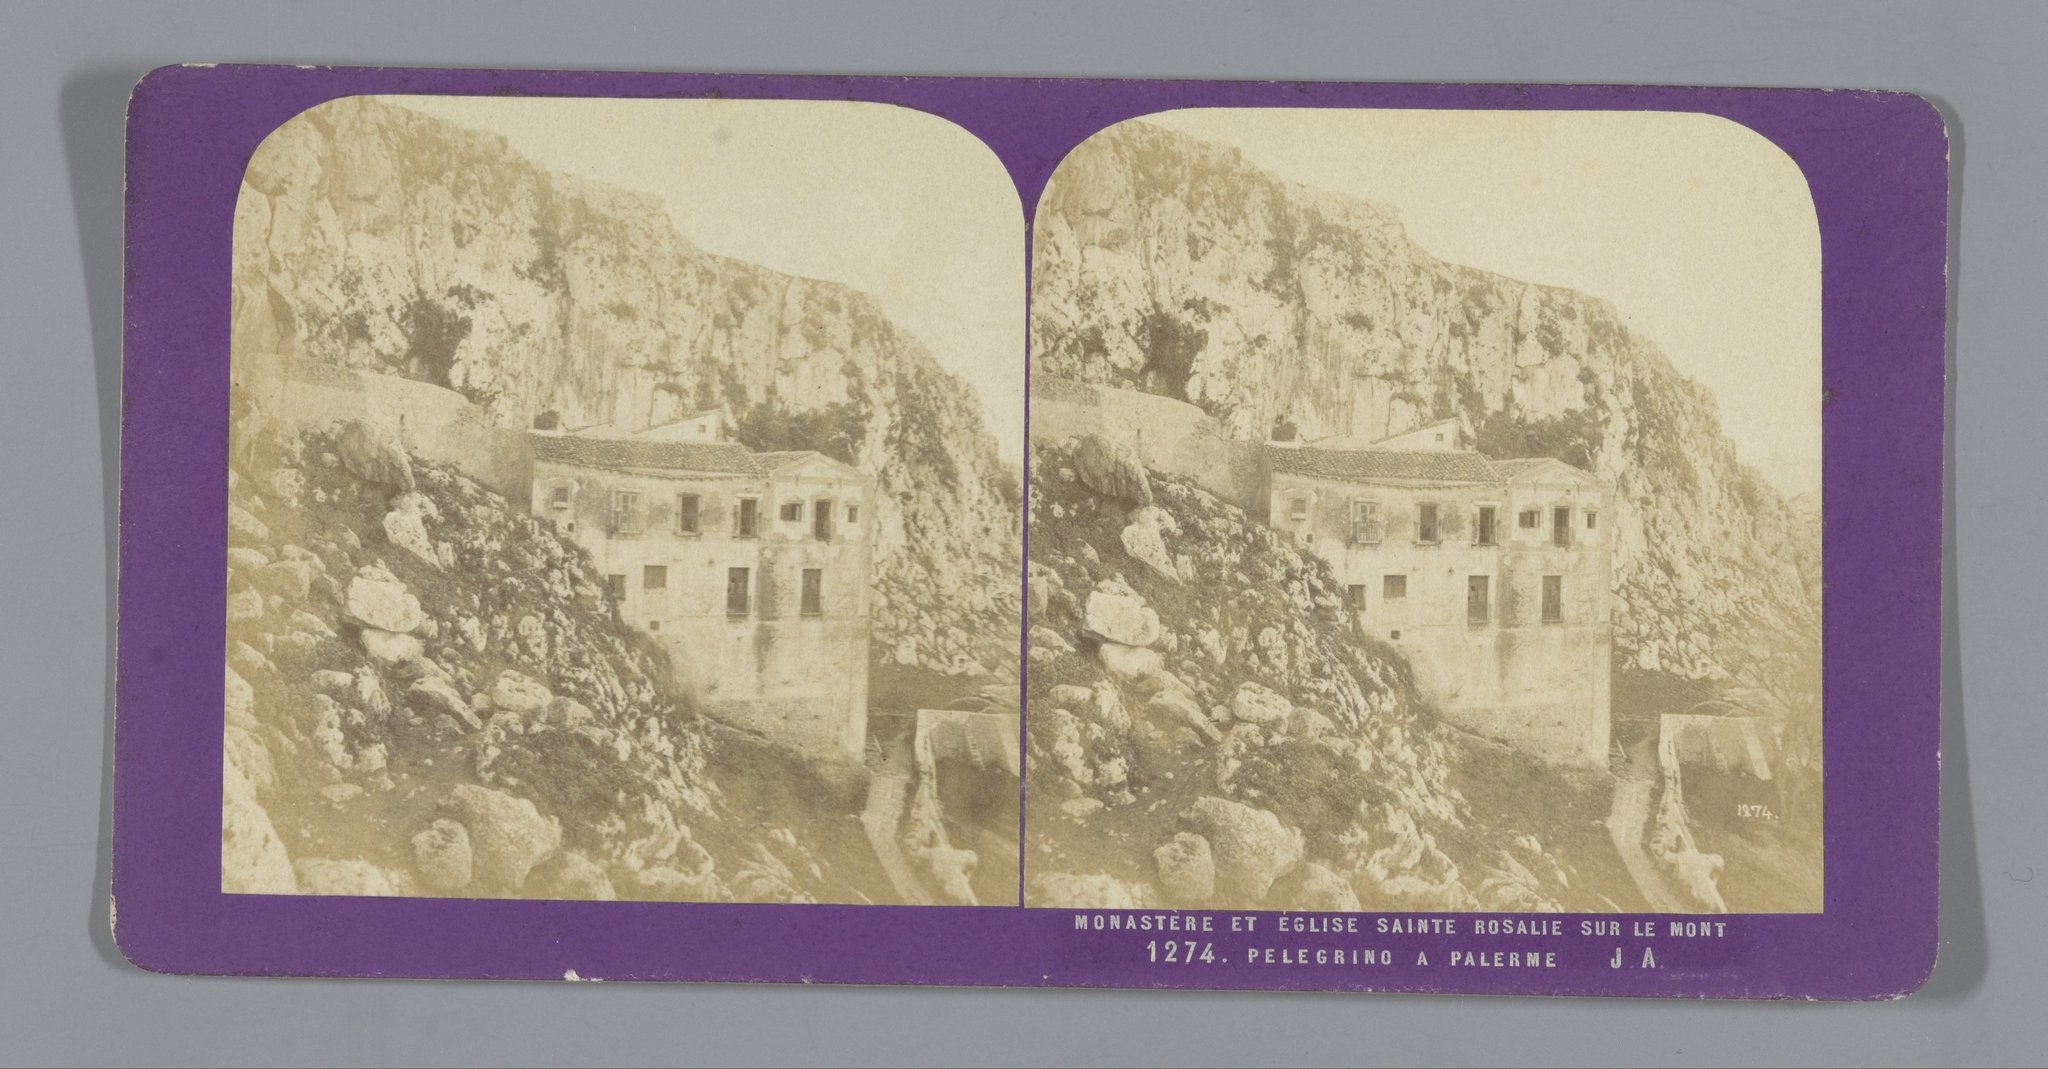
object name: stereograph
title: Gezicht op het Santuario di Santa Rosalia op de Monte Pellegrino, Palermo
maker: jean andrieu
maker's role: fotograaf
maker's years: 1816-1872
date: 1862-1876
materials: cardboard, paper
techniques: albumen print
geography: palermo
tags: abbey, monastery, convent ~ roman catholic church, mountains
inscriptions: number: ‘1274’